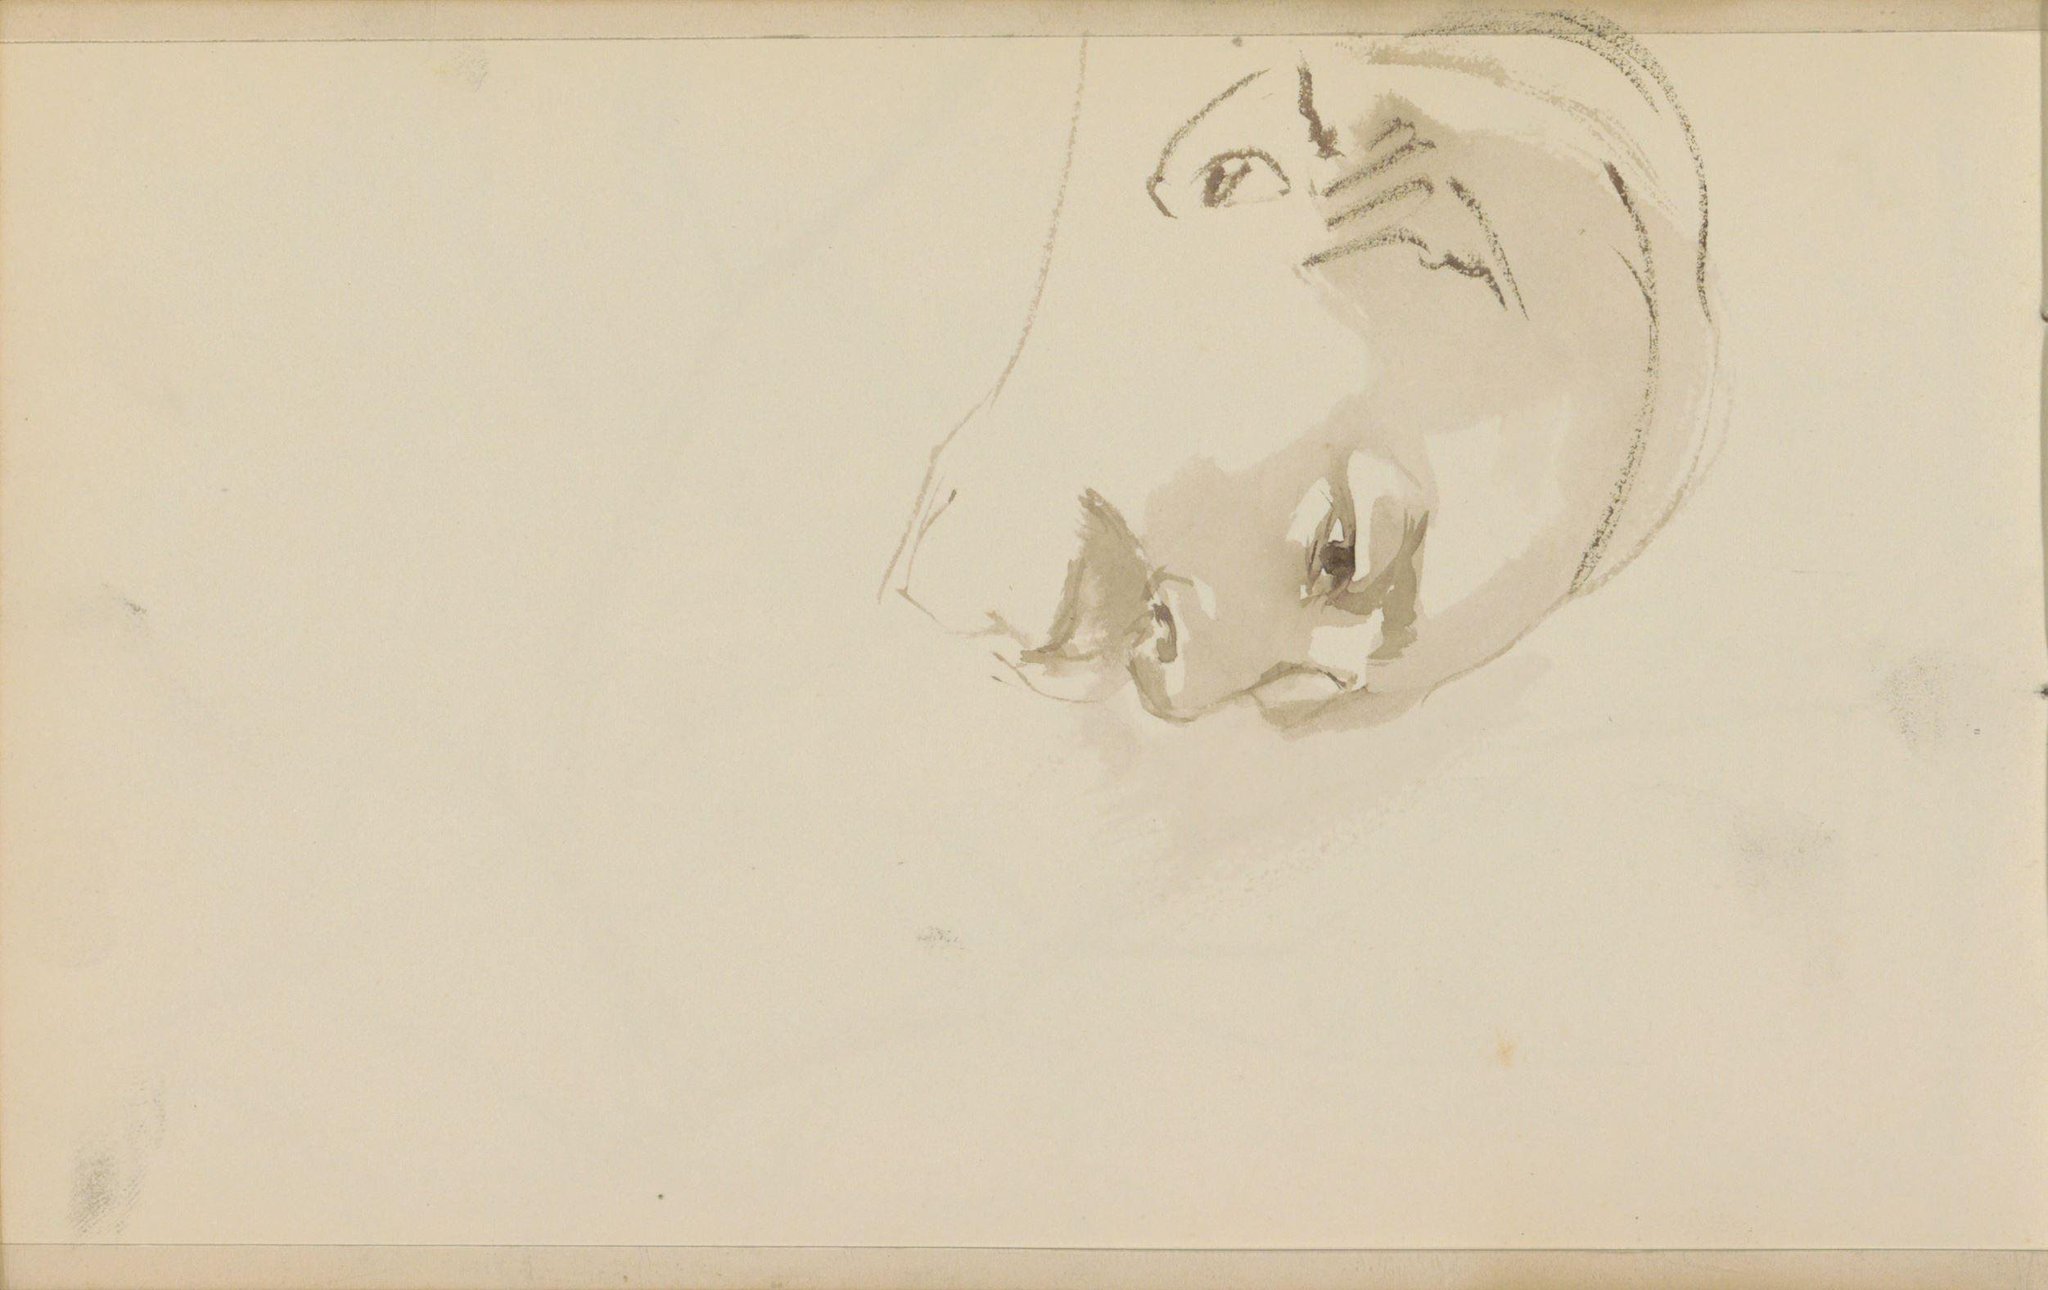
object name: sketchbook leaf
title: Kop van een man met een snor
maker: a.a.l. de grammont-hubrecht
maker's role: draughtsman, painter, print maker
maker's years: 1855-1913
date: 1892-1913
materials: ink, paper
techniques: brush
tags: head (human), adult man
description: Blad 11 verso uit een schetsboek met 31 bladen.